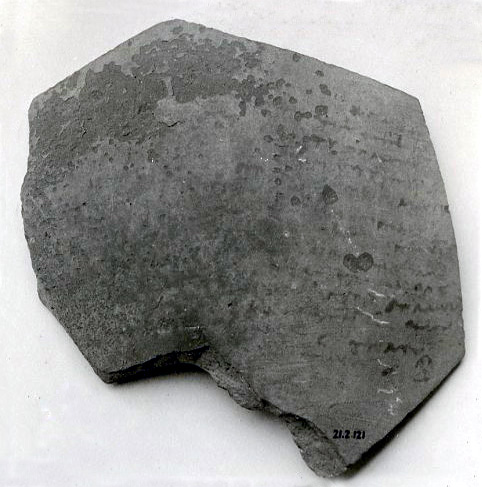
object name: ostracon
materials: ink, pottery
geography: egypt